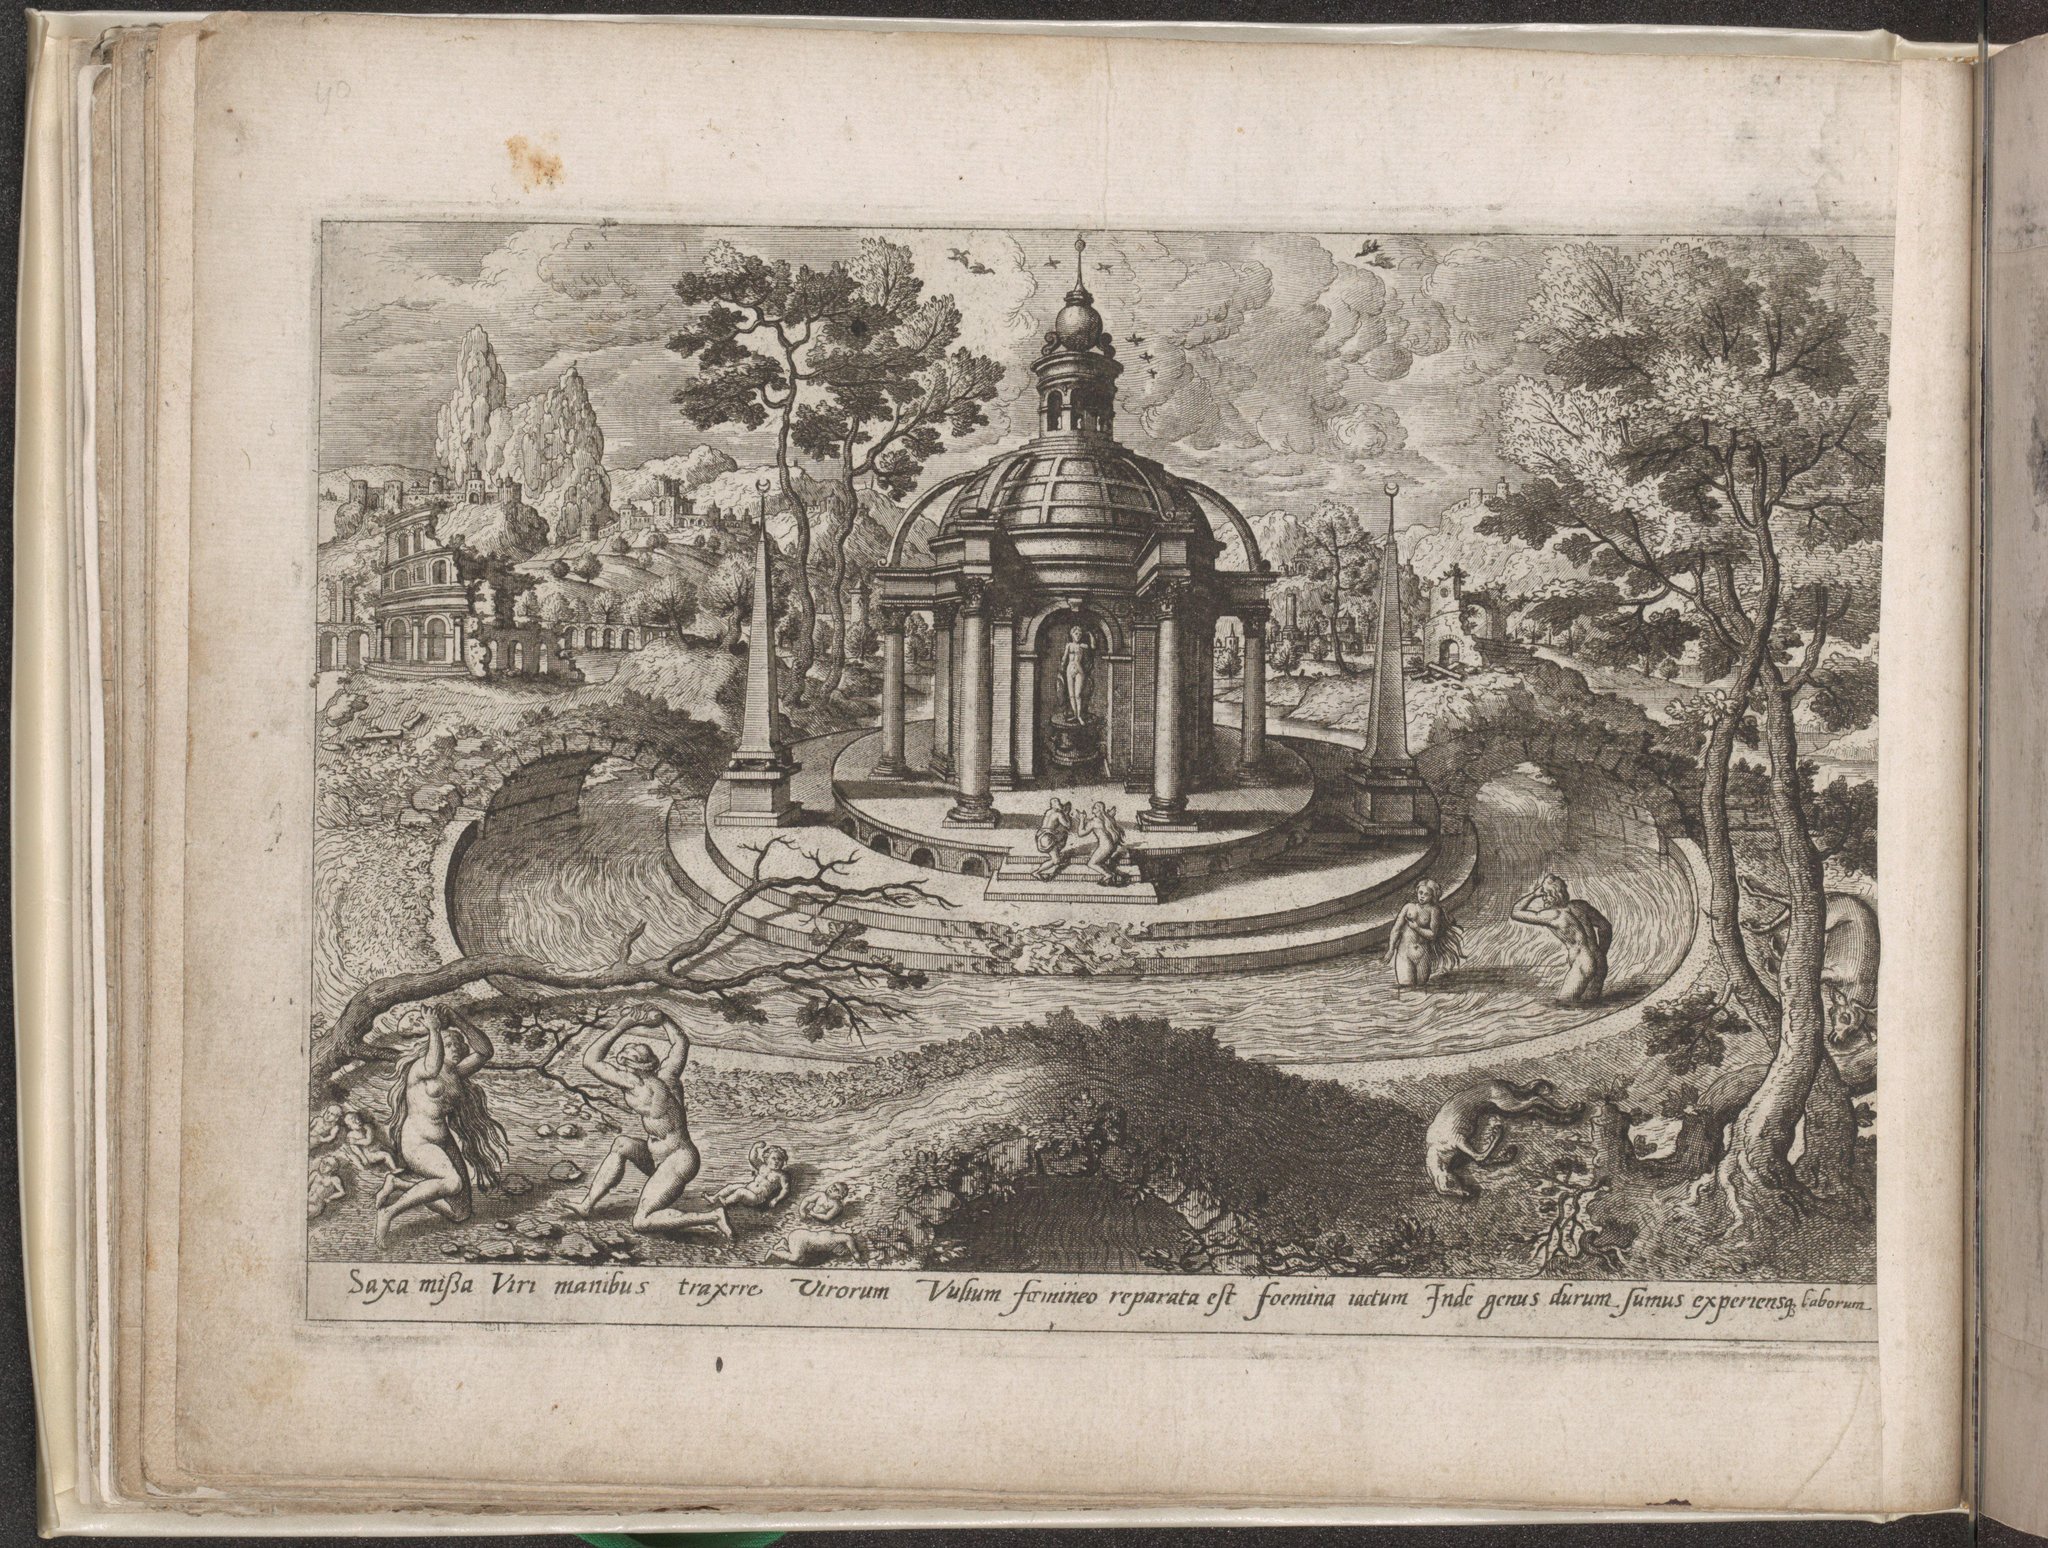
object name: print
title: Deucalion en Pyrrha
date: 1570-1574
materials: paper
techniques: etching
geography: antwerp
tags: deucalion and pyrrha pray, usually at the shrine of gaea-themis, deucalion's flood; jupiter sends a great flood to destroy mankind; deucalion and pyrrha afloat, stones turning into men: stones thrown by deucalion and pyrrha, as directed by the oracle of themis, turn into men (ovid, metamorphoses x 400)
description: Deucalion en Pyrrha staan in het water van een grote vloed, die de aarde heeft verwoest. In het midden knielen zij neer voor een orakel in een tempel. Ze krijgen van het orakel de raad om stenen achter zich te gooien. Links op de voorgrond doen zij dat. Op de grond veranderen de stenen in kinderen. Onder de voorstelling een verklarende tekst in het Latijn. Deze prent maakt deel uit van een album.